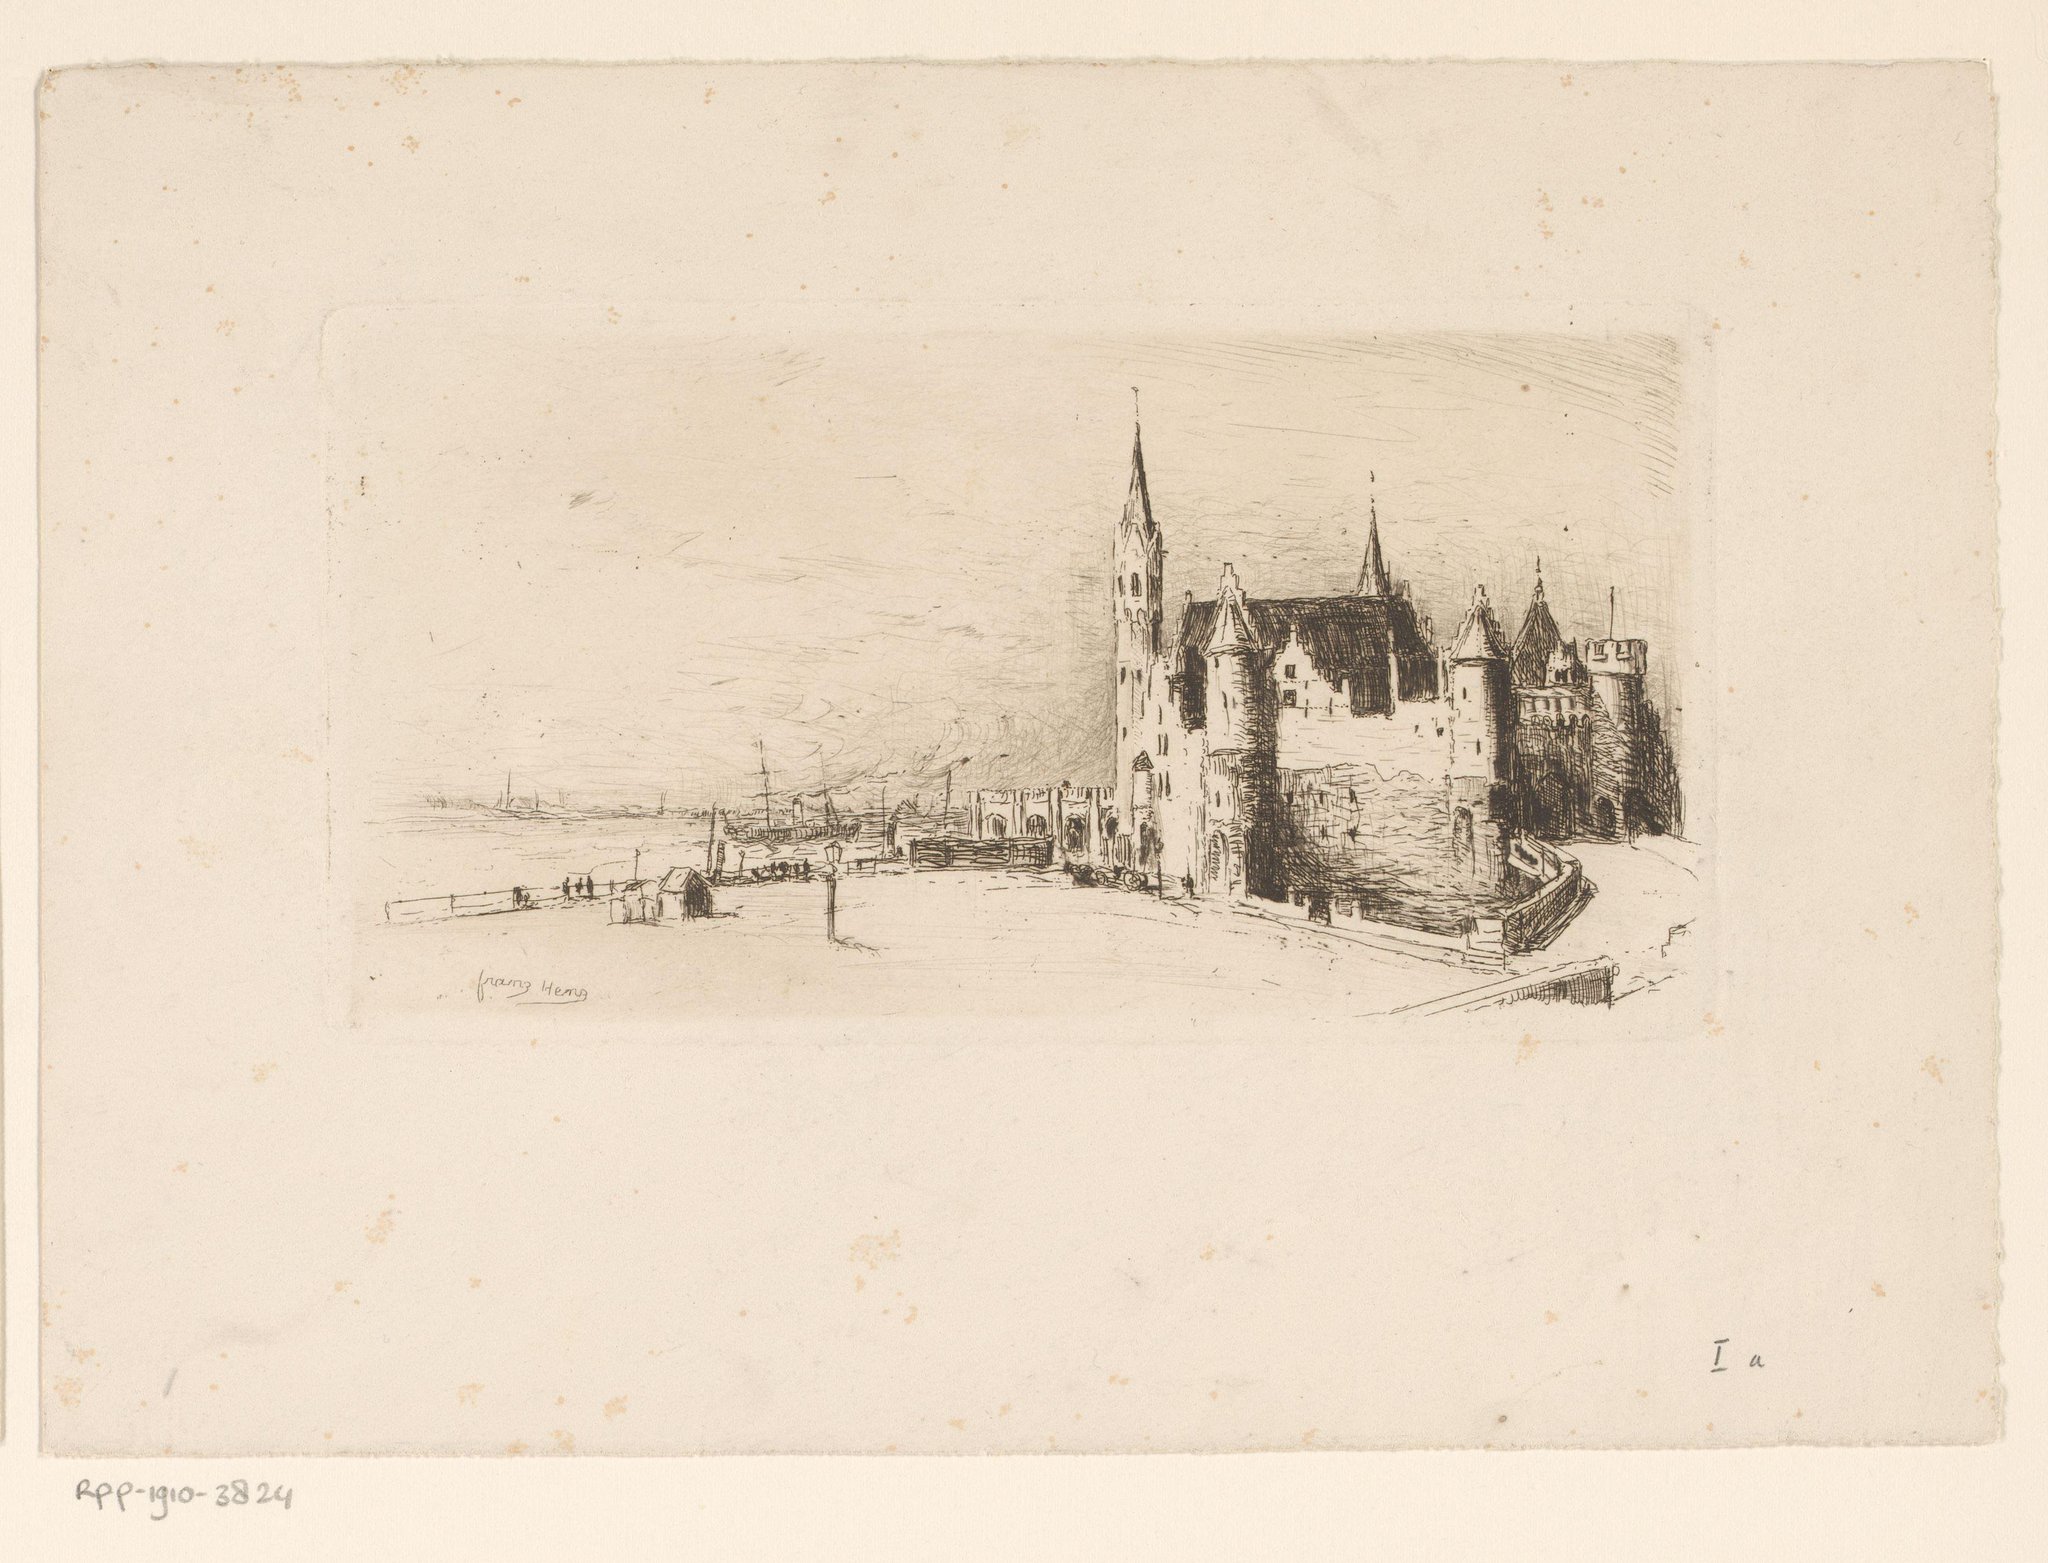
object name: print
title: Het Steen te Antwerpen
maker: frans hens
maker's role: print maker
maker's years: 1856-1928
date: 1866-1910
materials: paper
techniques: etching, intaglio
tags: harbour, castle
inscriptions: collector's mark: Lugt 2228